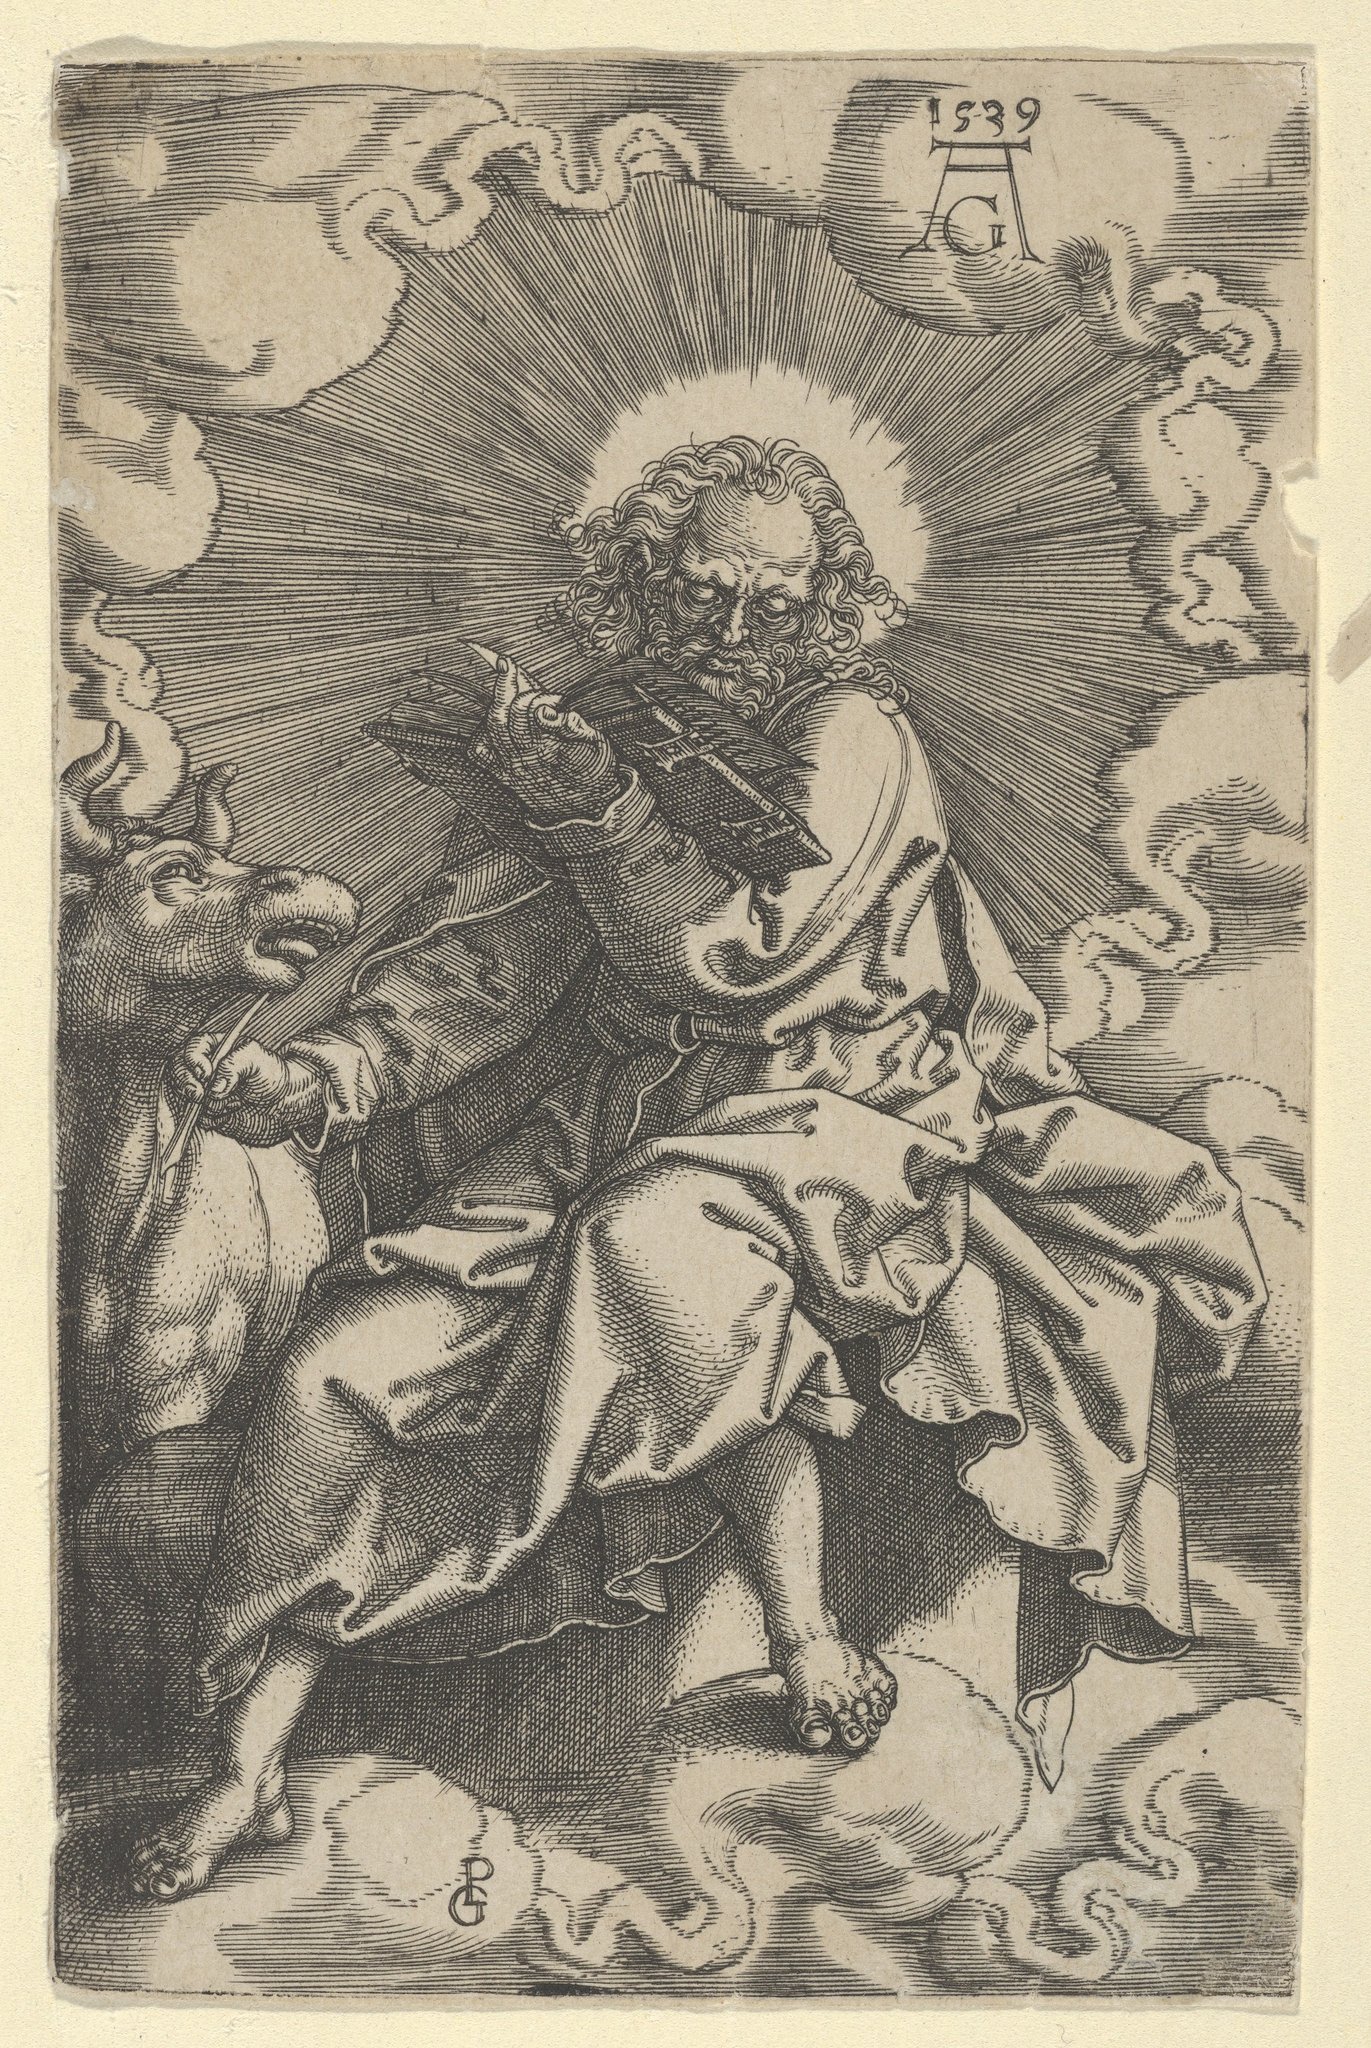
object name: print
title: Saint Luke, from "The Four Evangelists"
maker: heinrich aldegrever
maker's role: artist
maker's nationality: german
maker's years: 1502-1561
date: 1539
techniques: engraving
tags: animals,books,men,saints